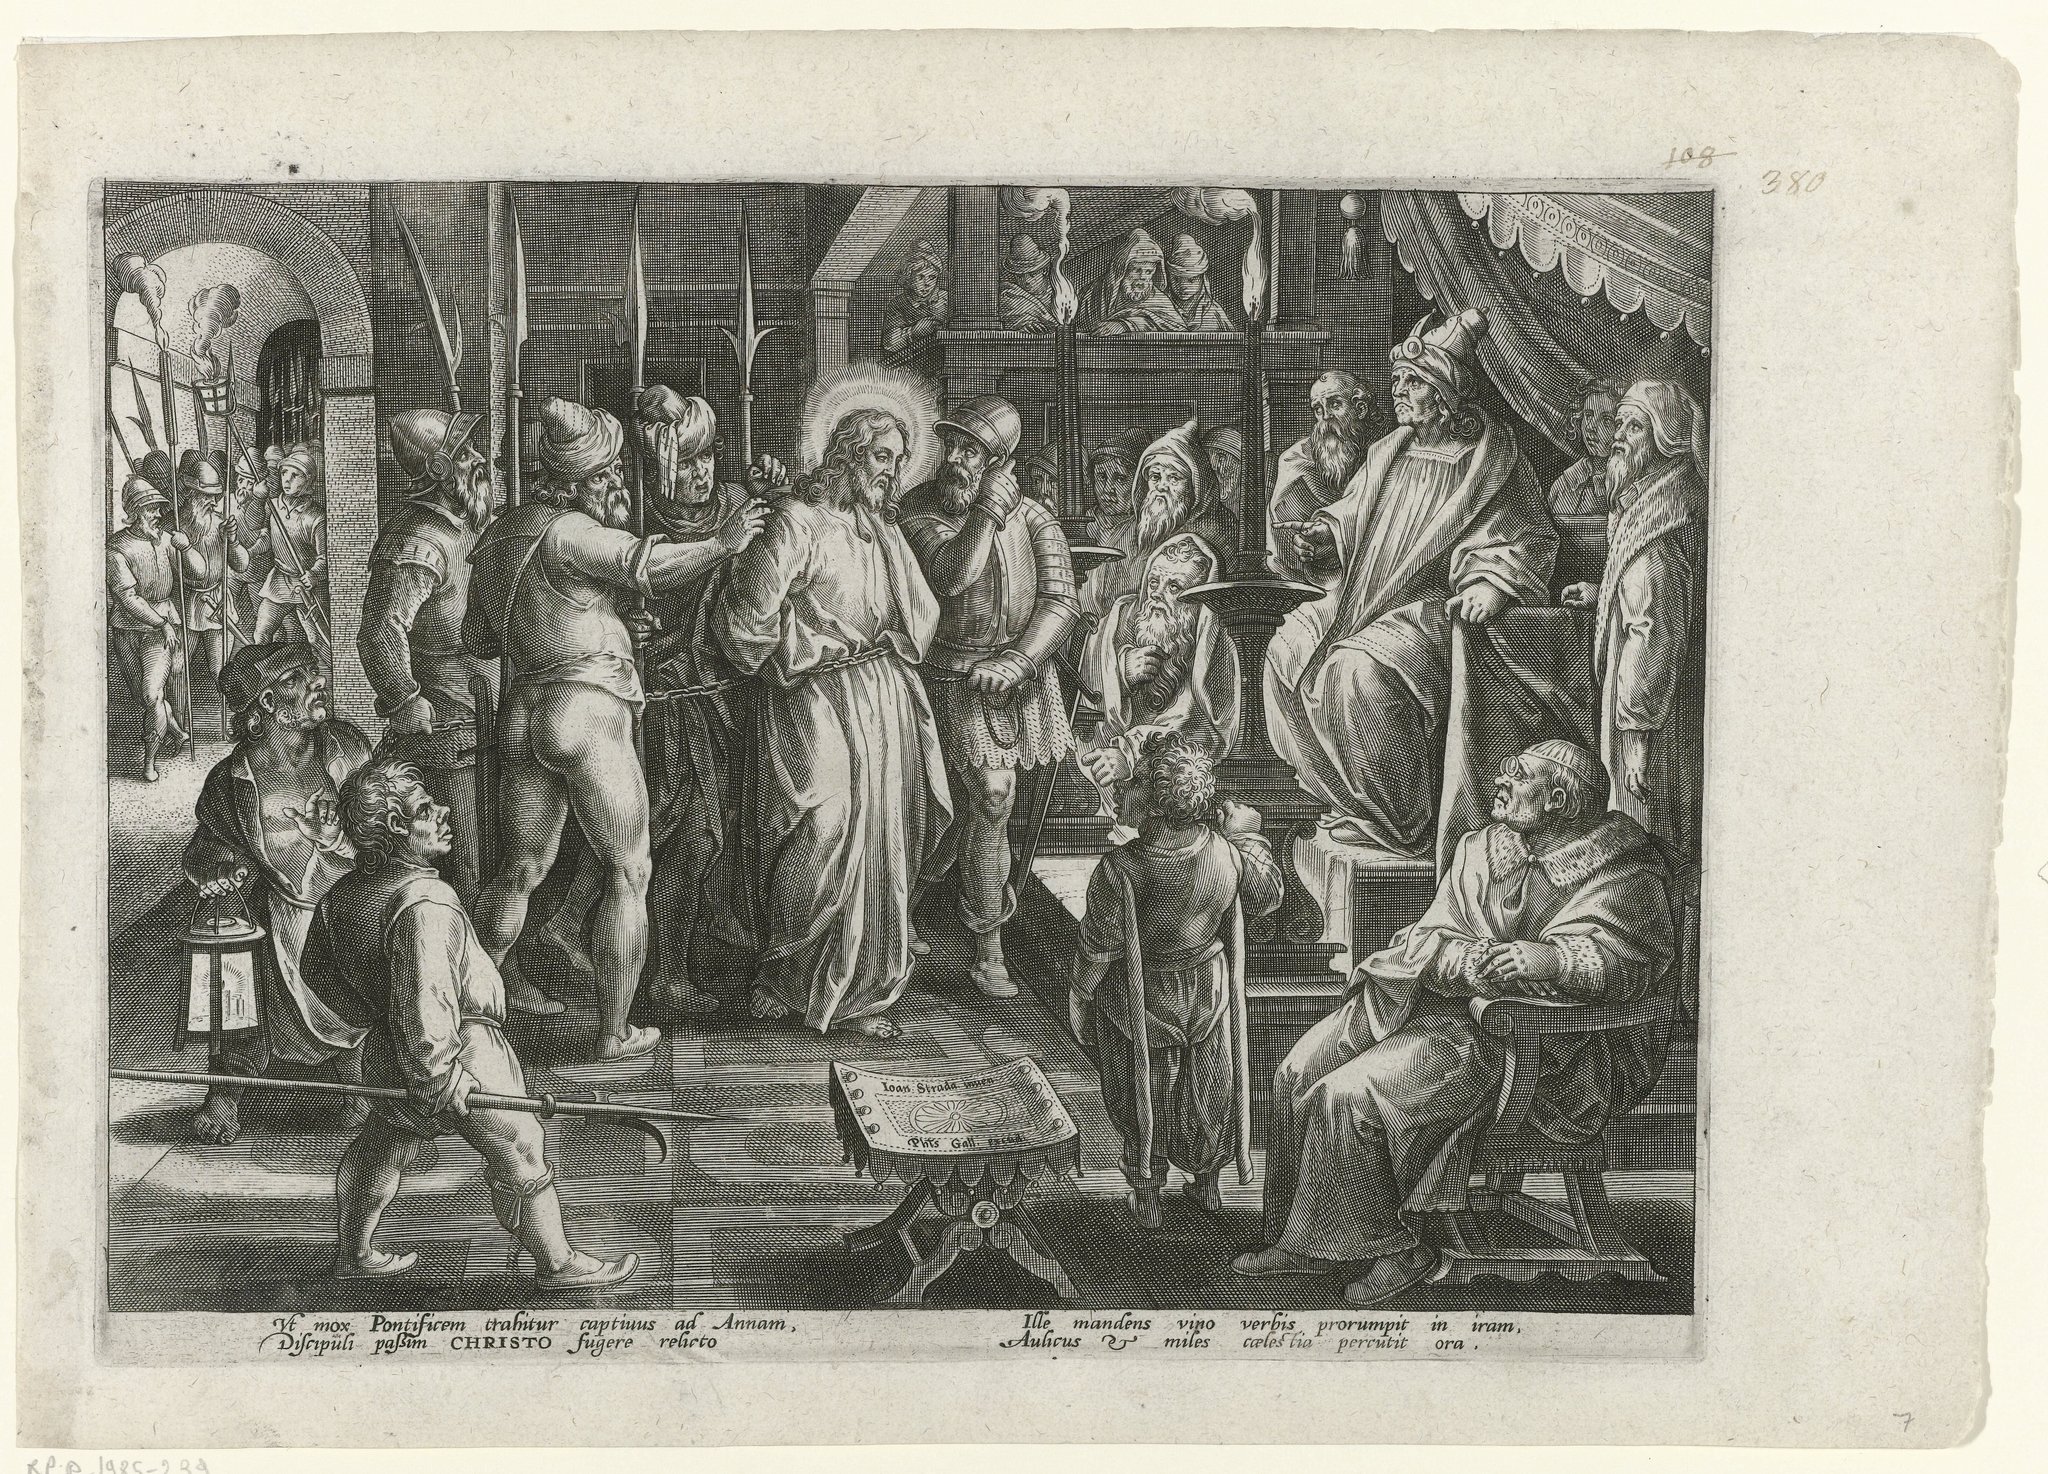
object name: print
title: Passie, dood en wederopstanding van Christus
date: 1585-1586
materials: paper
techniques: engraving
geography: florence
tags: christ before annas (hanna); maybe a soldier about to strike christ (john 18:13, 18:19-24)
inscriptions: collector's mark: 2760, watermark:, number: ‘380’, collector's mark: Lugt 2228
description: Christus staat, gebonden voor de troon van hogepriester Annas. Rondom hem gewapende soldaten. Een van de soldaten wilt Christus slaan. De prent heeft een Latijns onderschrift en maakt deel uit van een serie over de passie, dood en wederopstanding van Christus